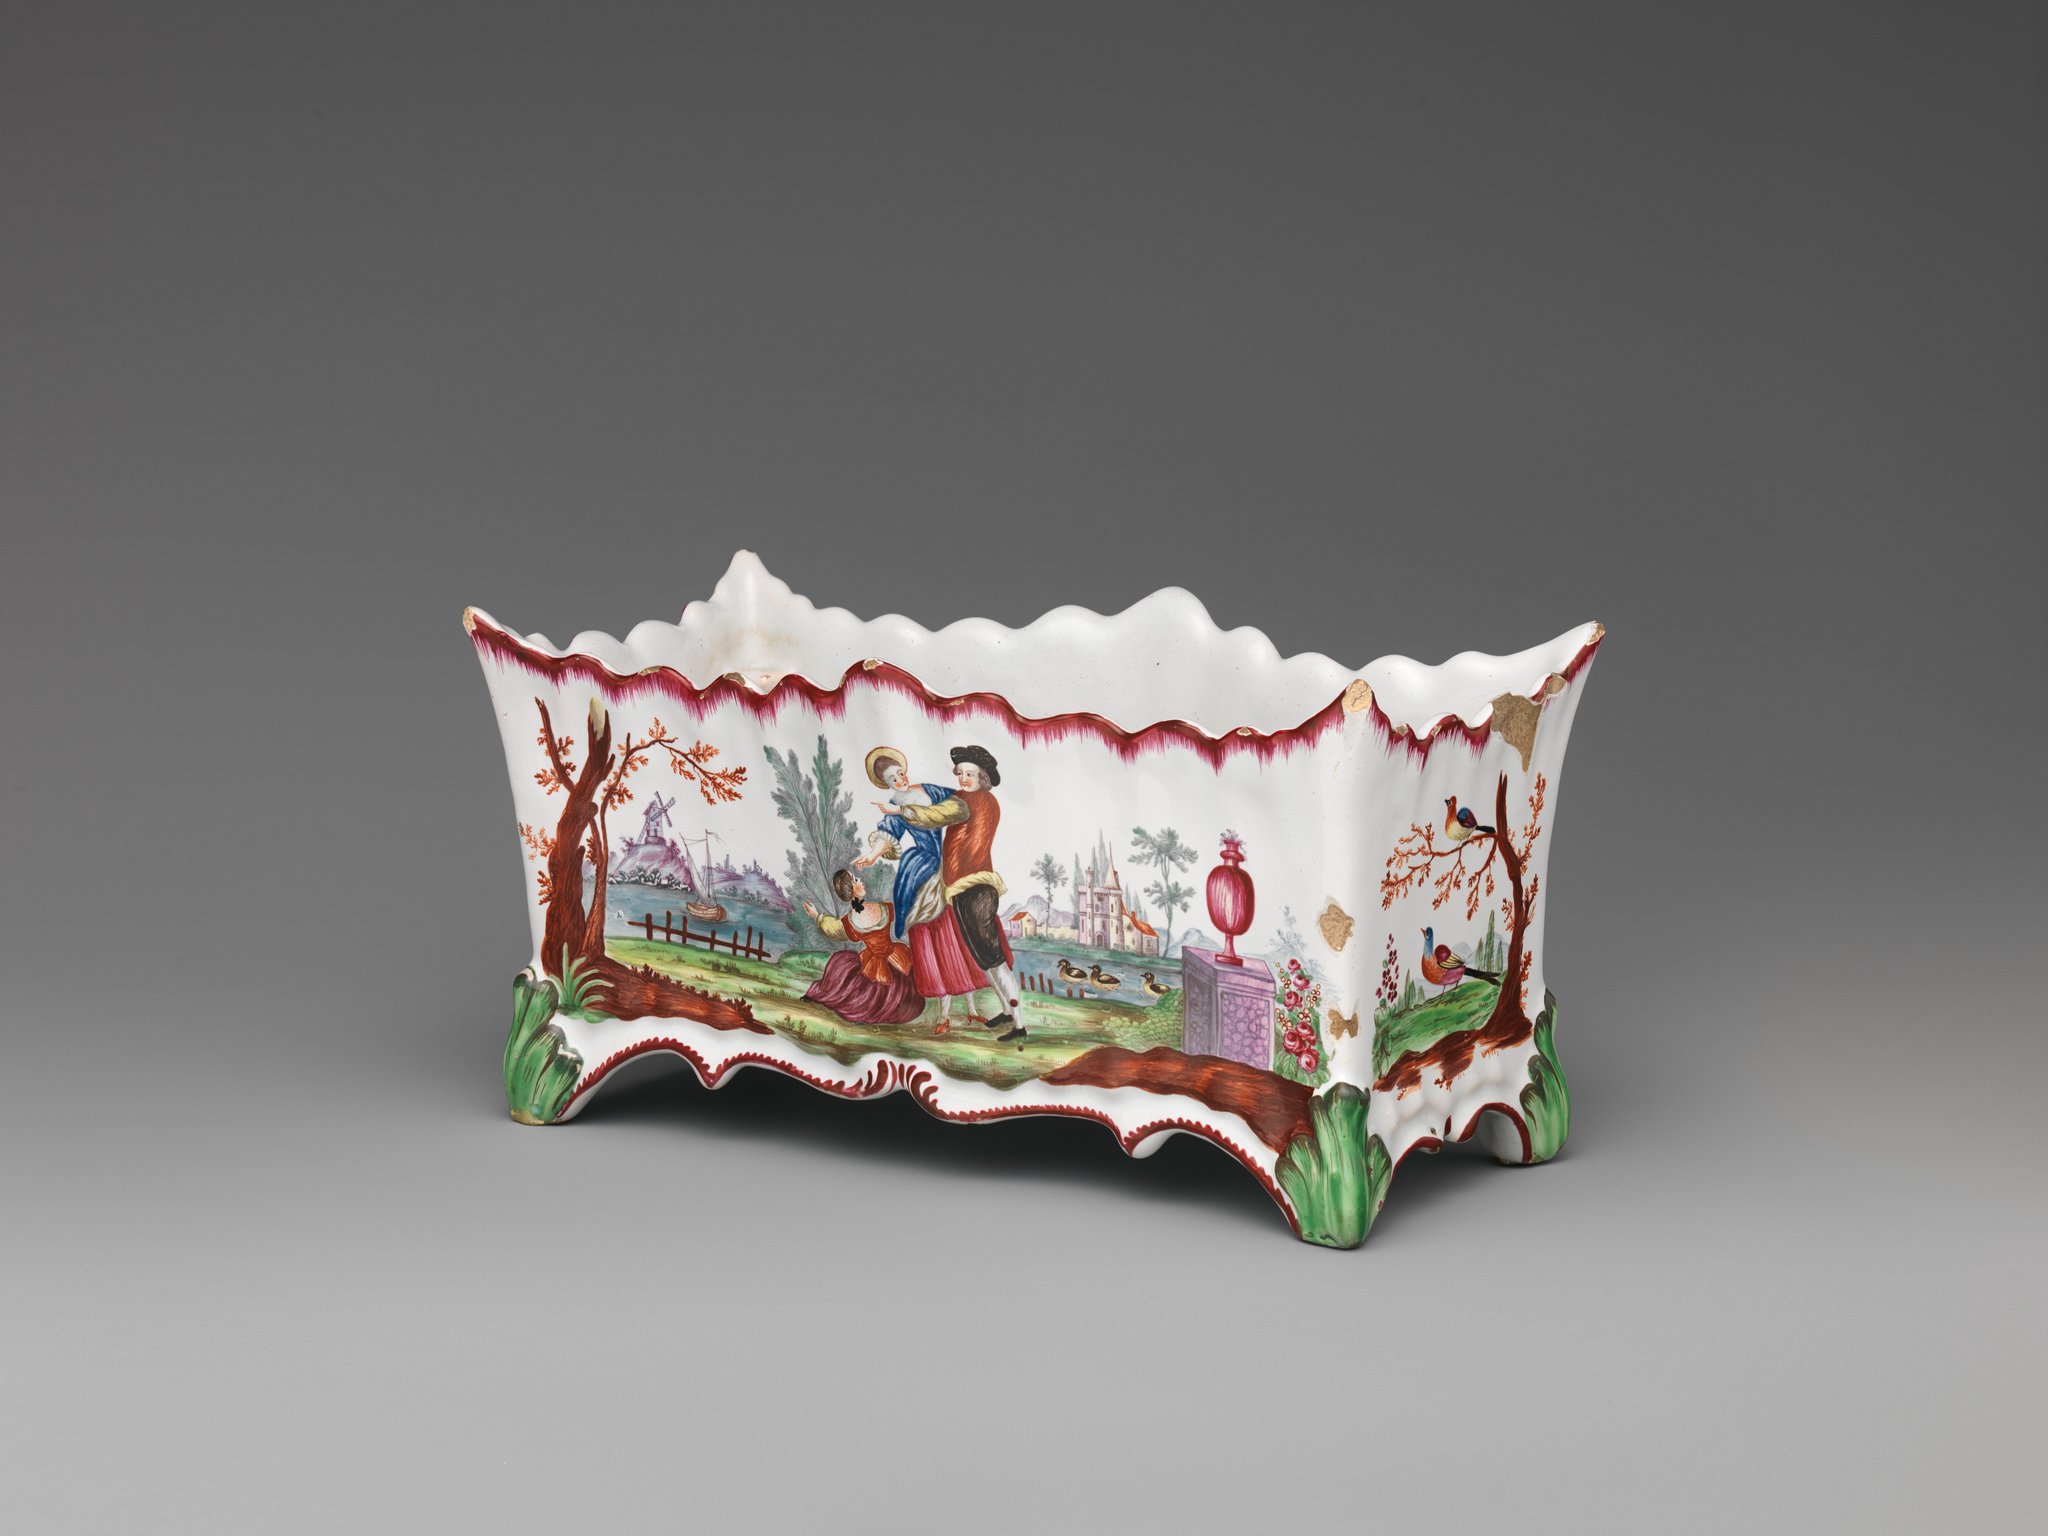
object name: jardinière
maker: levavasseur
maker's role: manufactory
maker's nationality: french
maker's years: 1715-1825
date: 1775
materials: faience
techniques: glazing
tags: gardens,men,women,trees